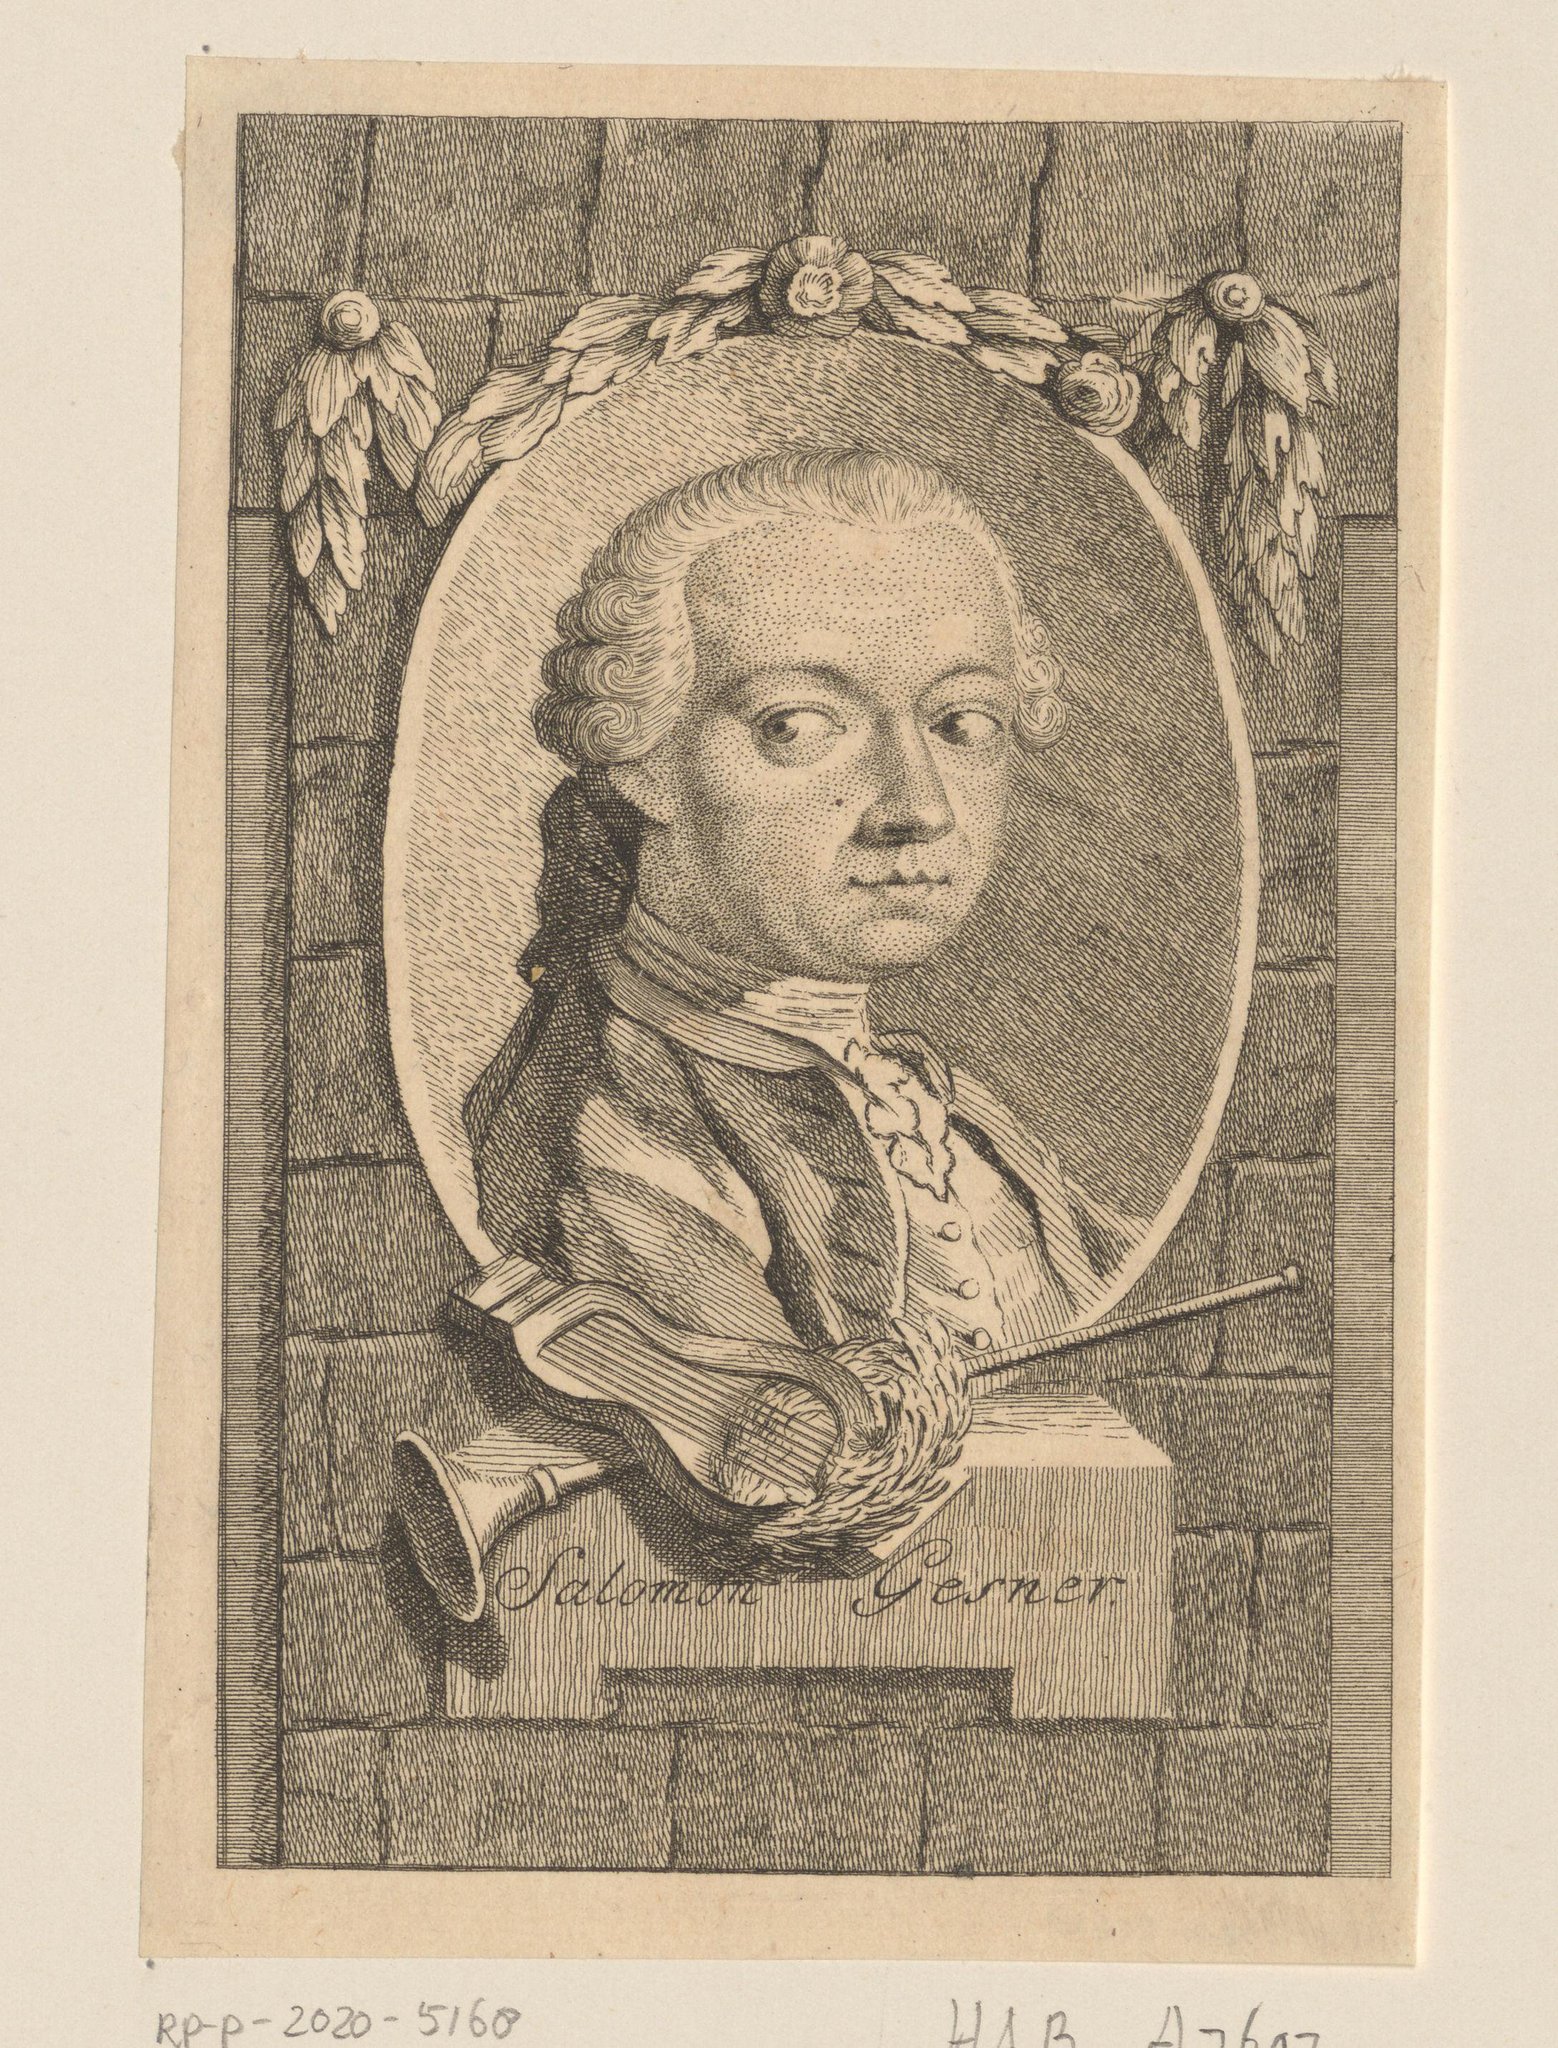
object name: print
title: Portret van Salomon Gessner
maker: Anonymous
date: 1740-1788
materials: paper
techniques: engraving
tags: painter, print maker, salomon gessner, historical persons, portrait, self-portrait of painter, writer, poet, author